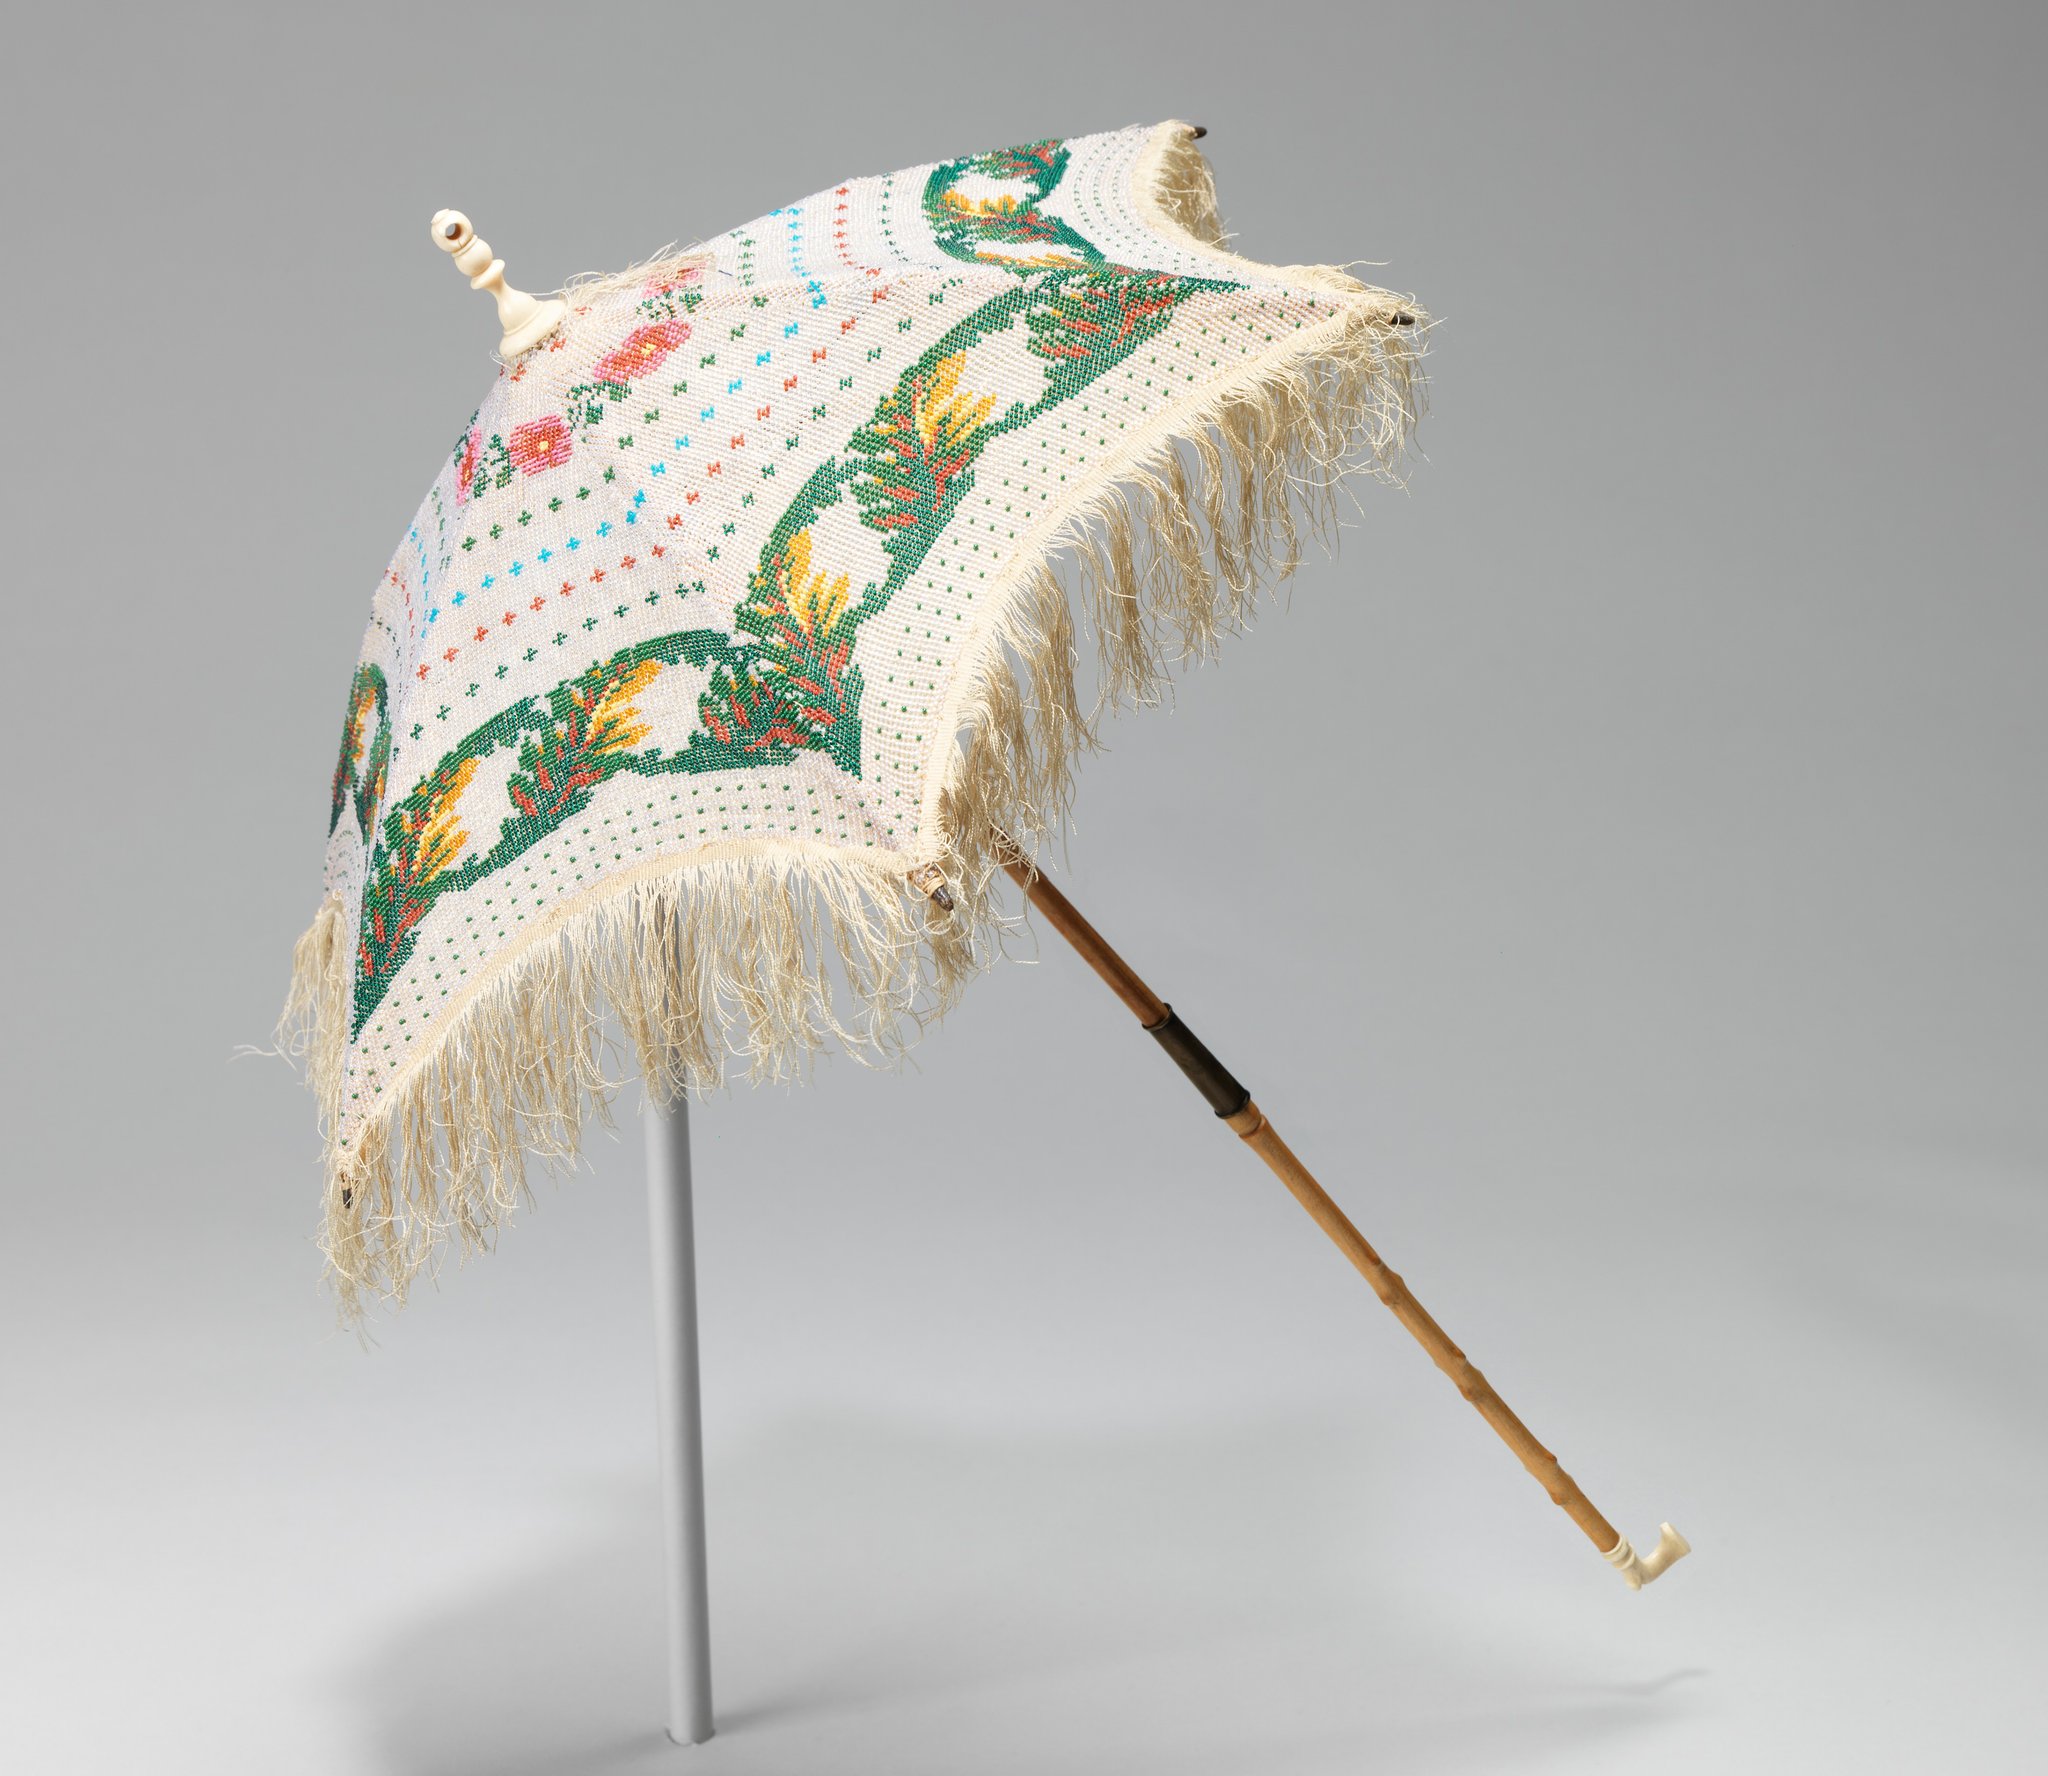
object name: parasol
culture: american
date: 1870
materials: glass, ivory, linen, metal, silk, wood